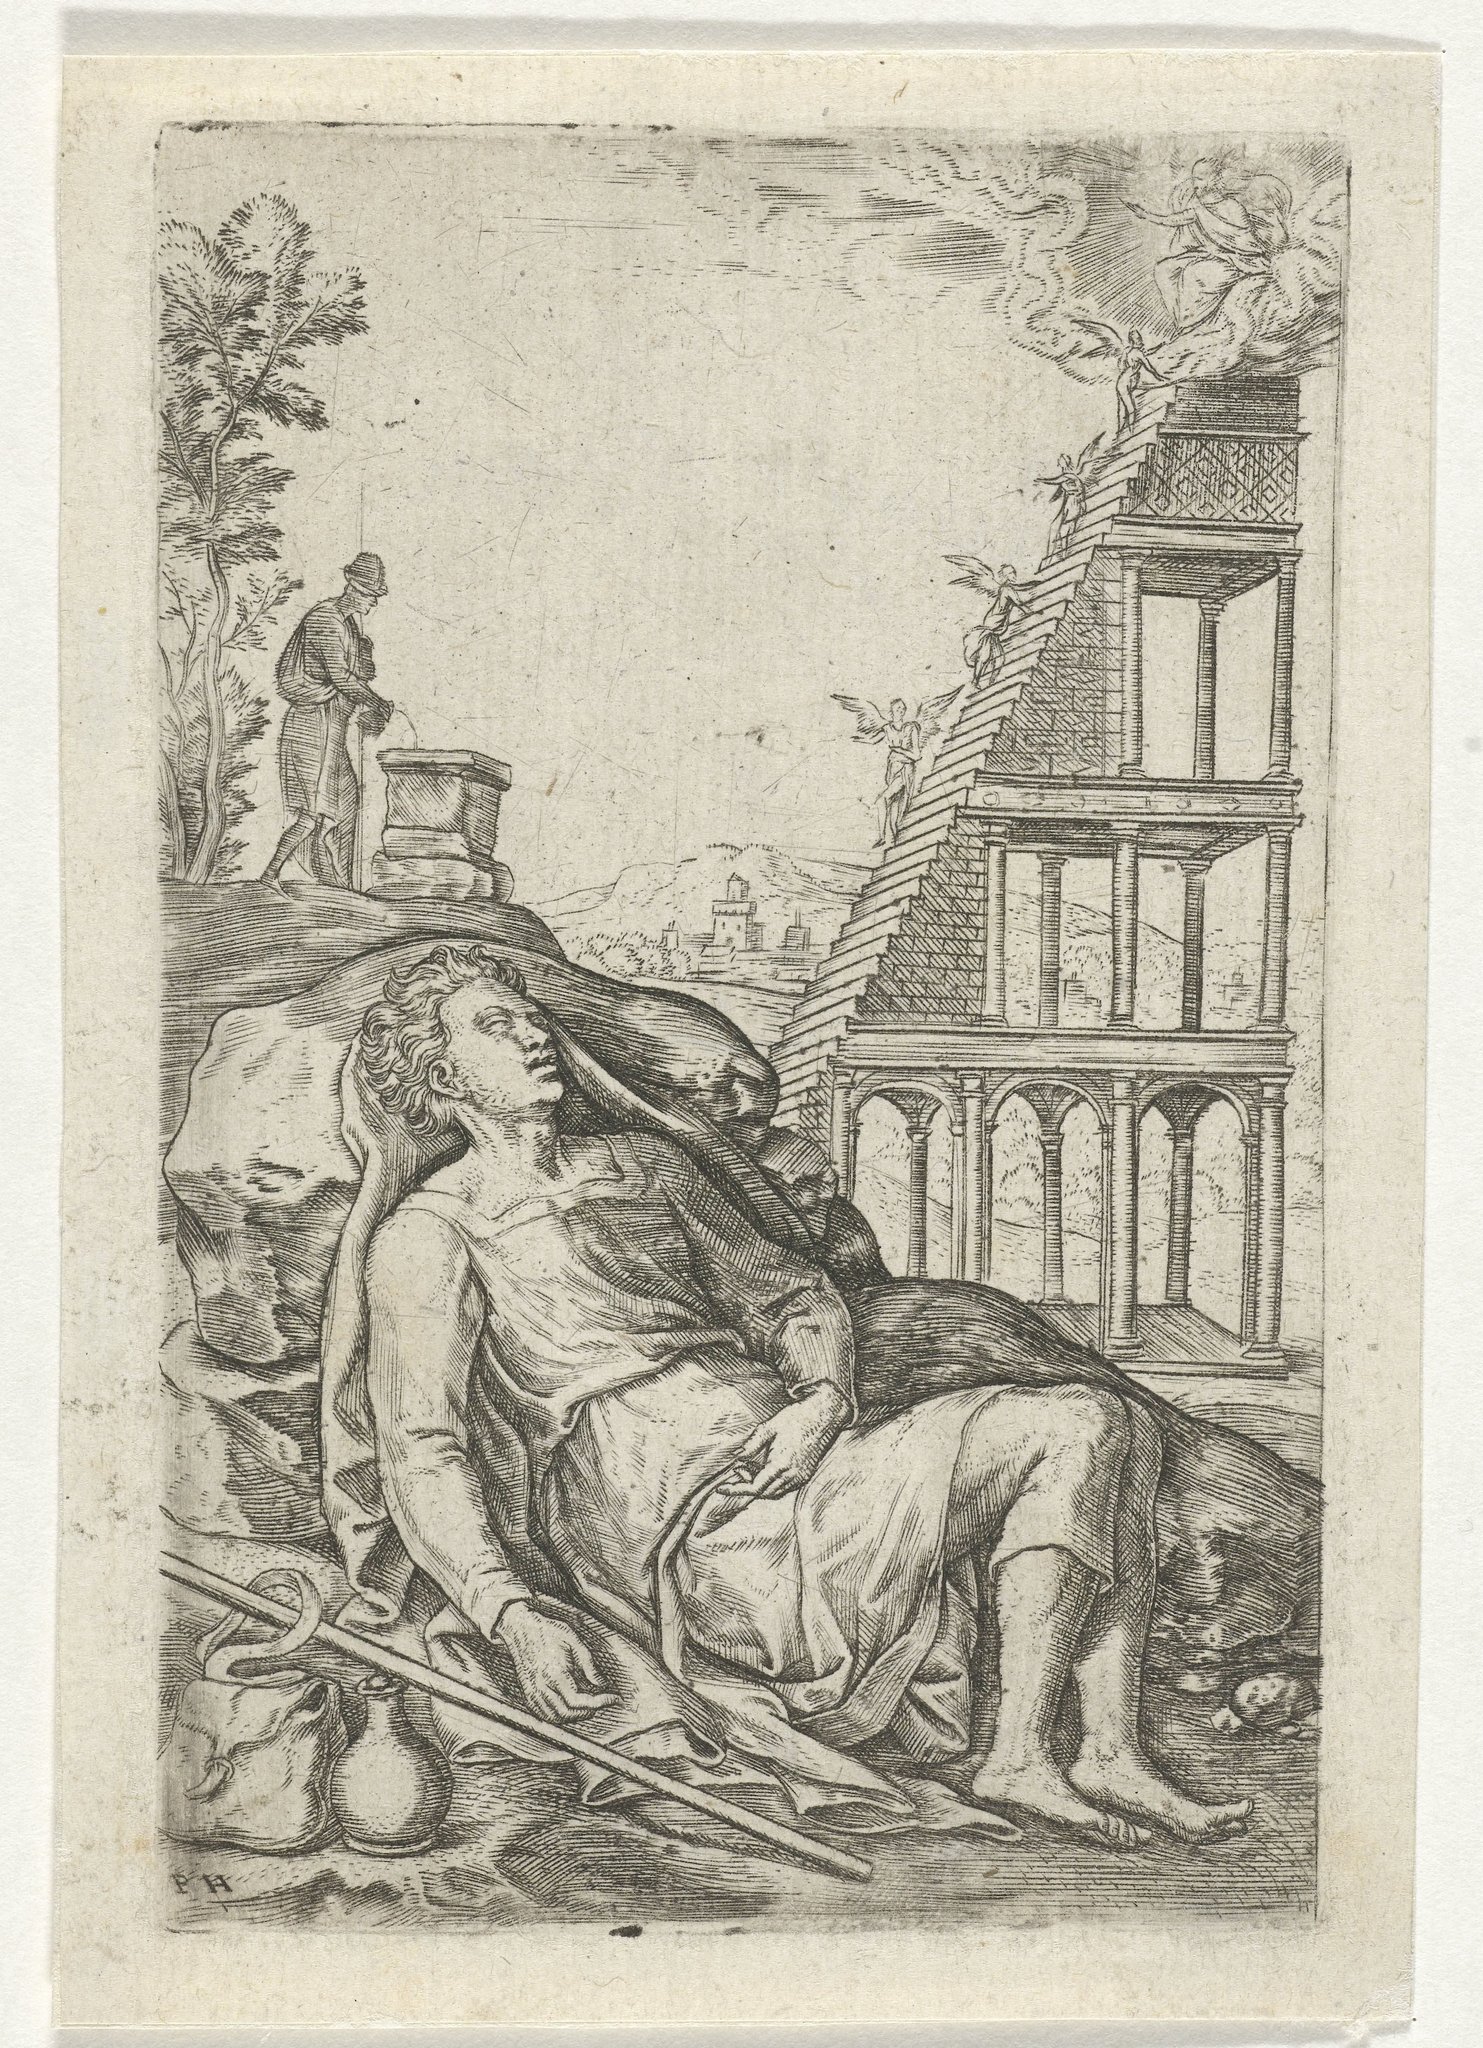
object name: print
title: Jakobs droom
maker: pieter huys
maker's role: draughtsman, painter, print maker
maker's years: 1509-1591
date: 1545-1577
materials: paper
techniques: engraving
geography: antwerp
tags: the dream of jacob: while sleeping on the ground with a stone for pillow jacob sees a ladder reaching from earth to heaven with angels going up and down; usually with god at the top of the ladder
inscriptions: collector's mark: Lugt 2233, collector's mark: Lugt 2228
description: Jakob ligt te slapen met zijn hoofd op een steen, zijn staf, tas en kruik naast zich. Rechts is zijn droom zichtbaar: een trap naar de hemel, waarop vier engelen lopen. Bovenaan de trap troont God. Linksachter wijdt Jakob de steen waarop hij heeft geslapen door er olie over uit te gieten.